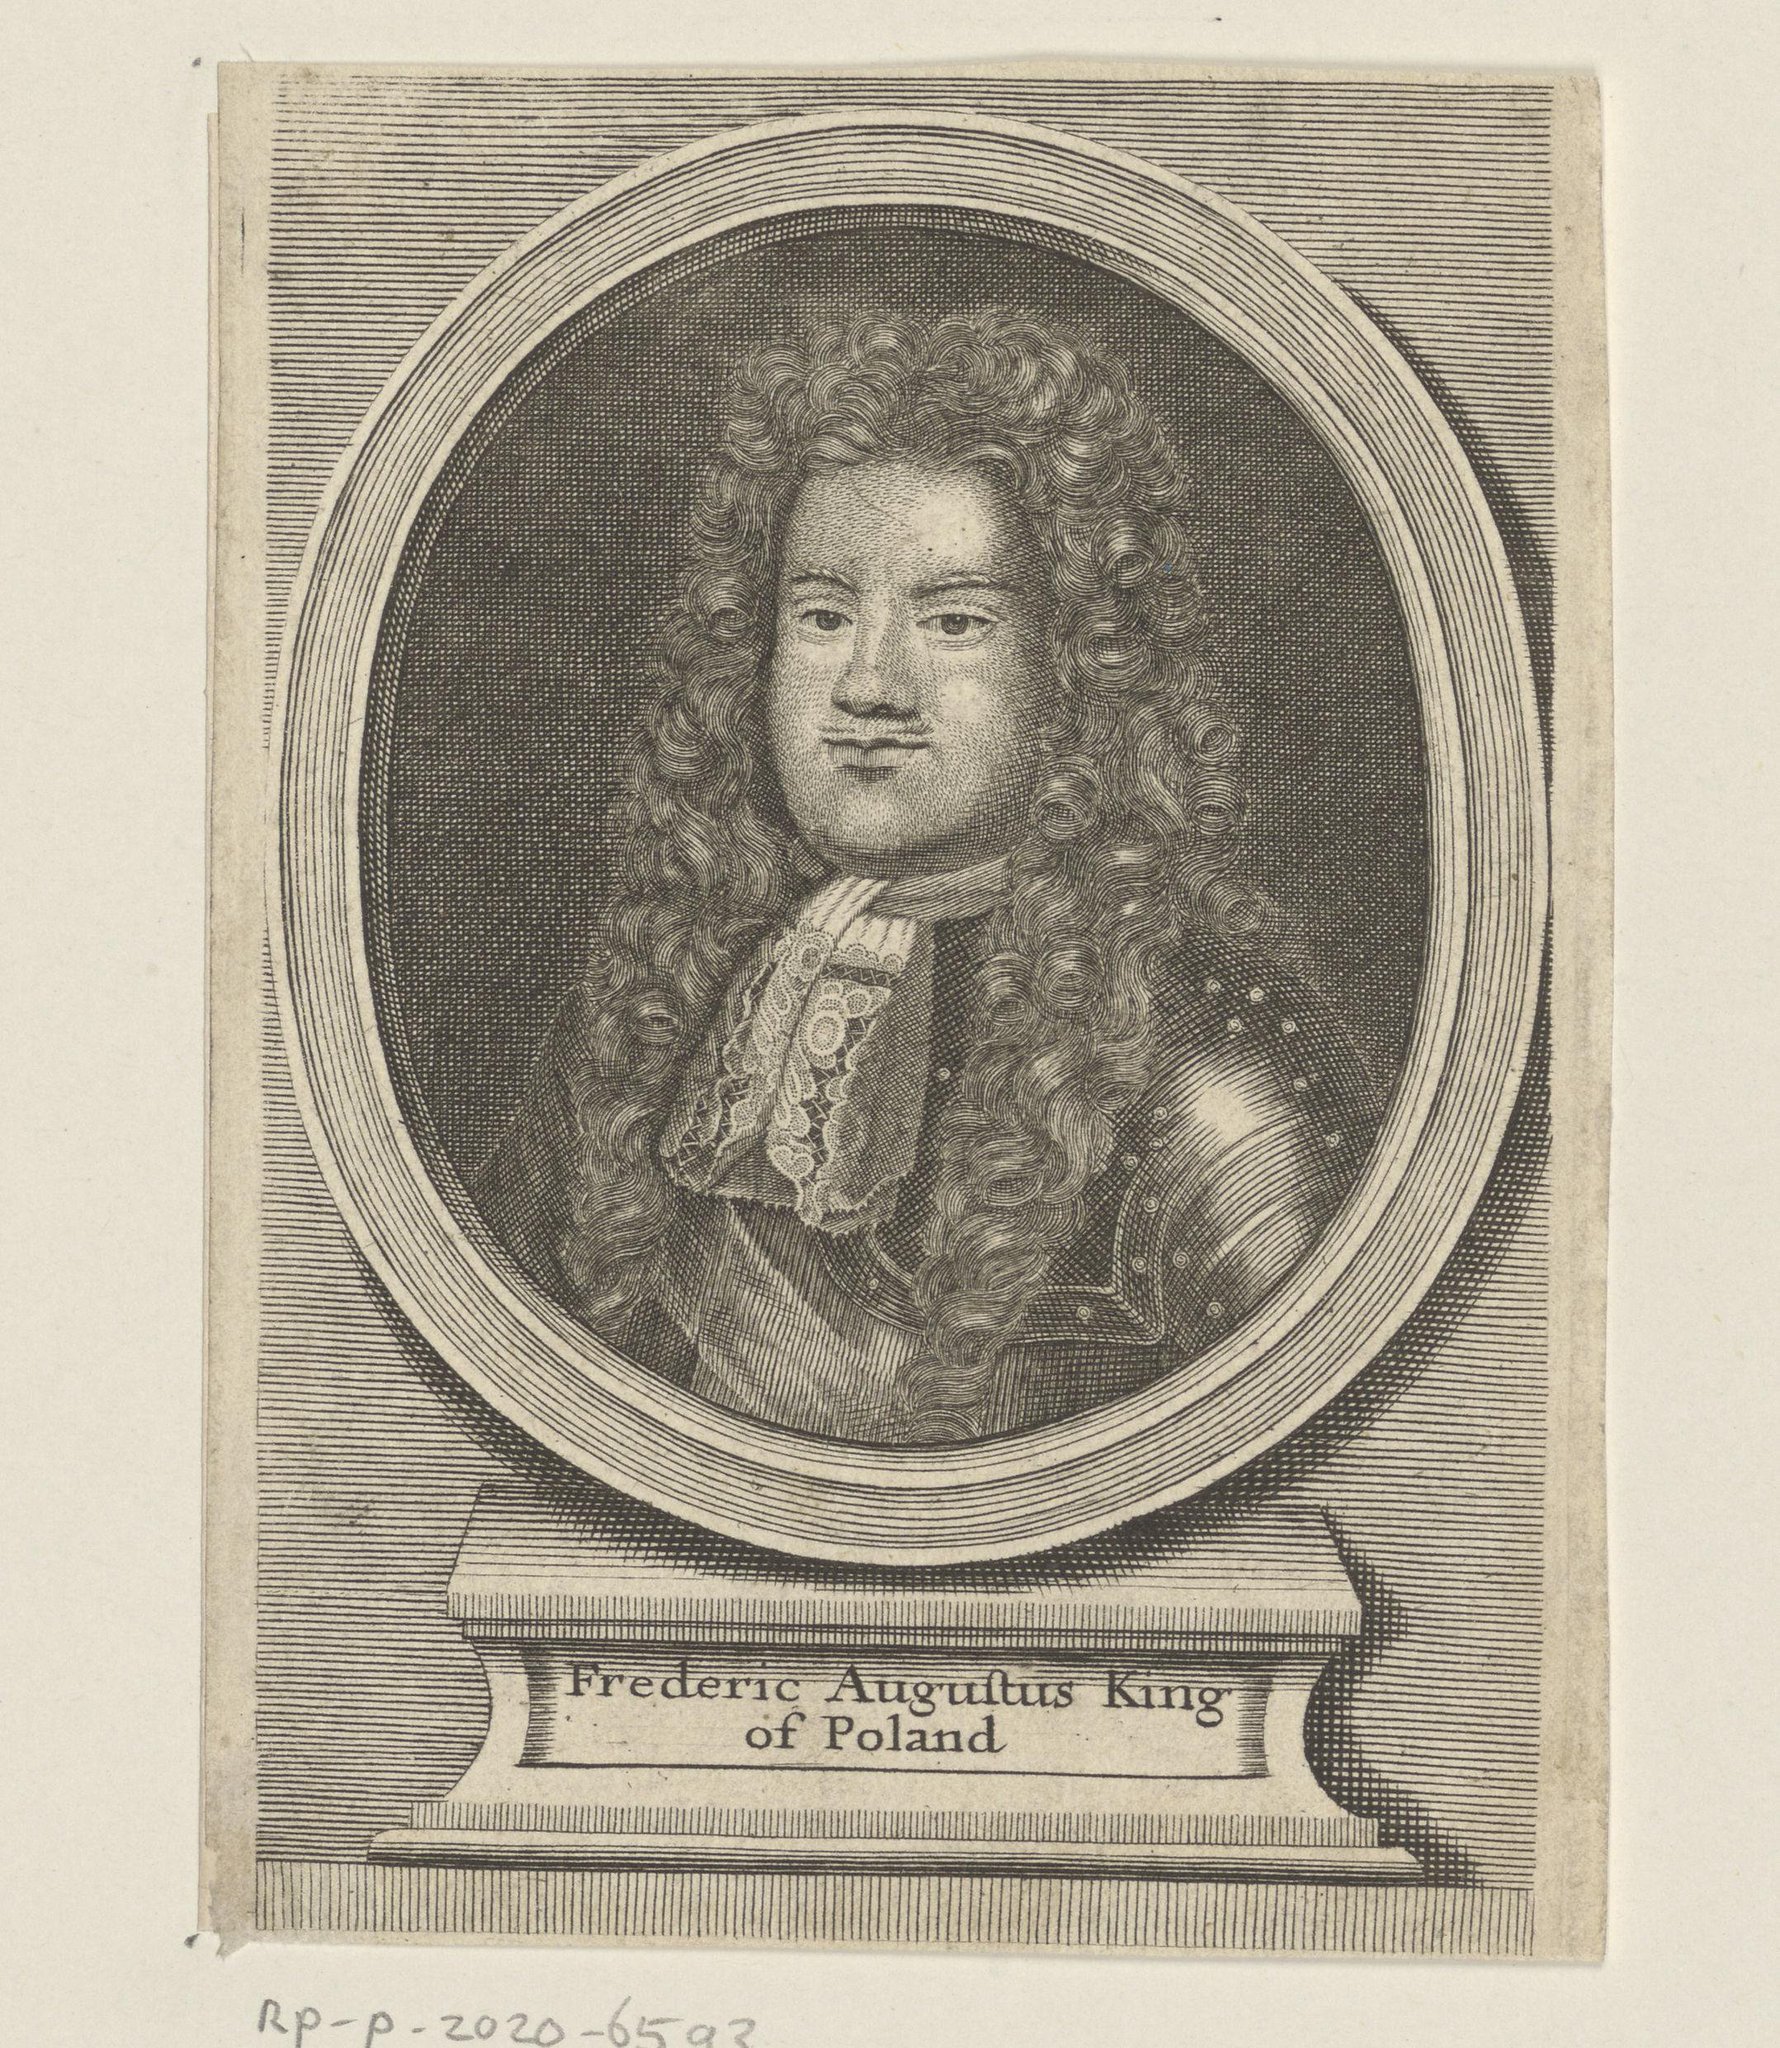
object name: book illustration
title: Portret van August II van Polen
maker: Anonymous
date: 1704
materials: paper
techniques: engraving, etching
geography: england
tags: august ii (king of poland), ornament ~ medallion, historical persons, king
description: Prent waarschijnlijk uit: Beaumont, John. The Present State of the Universe (...). Londen: John Nutt, 1704.